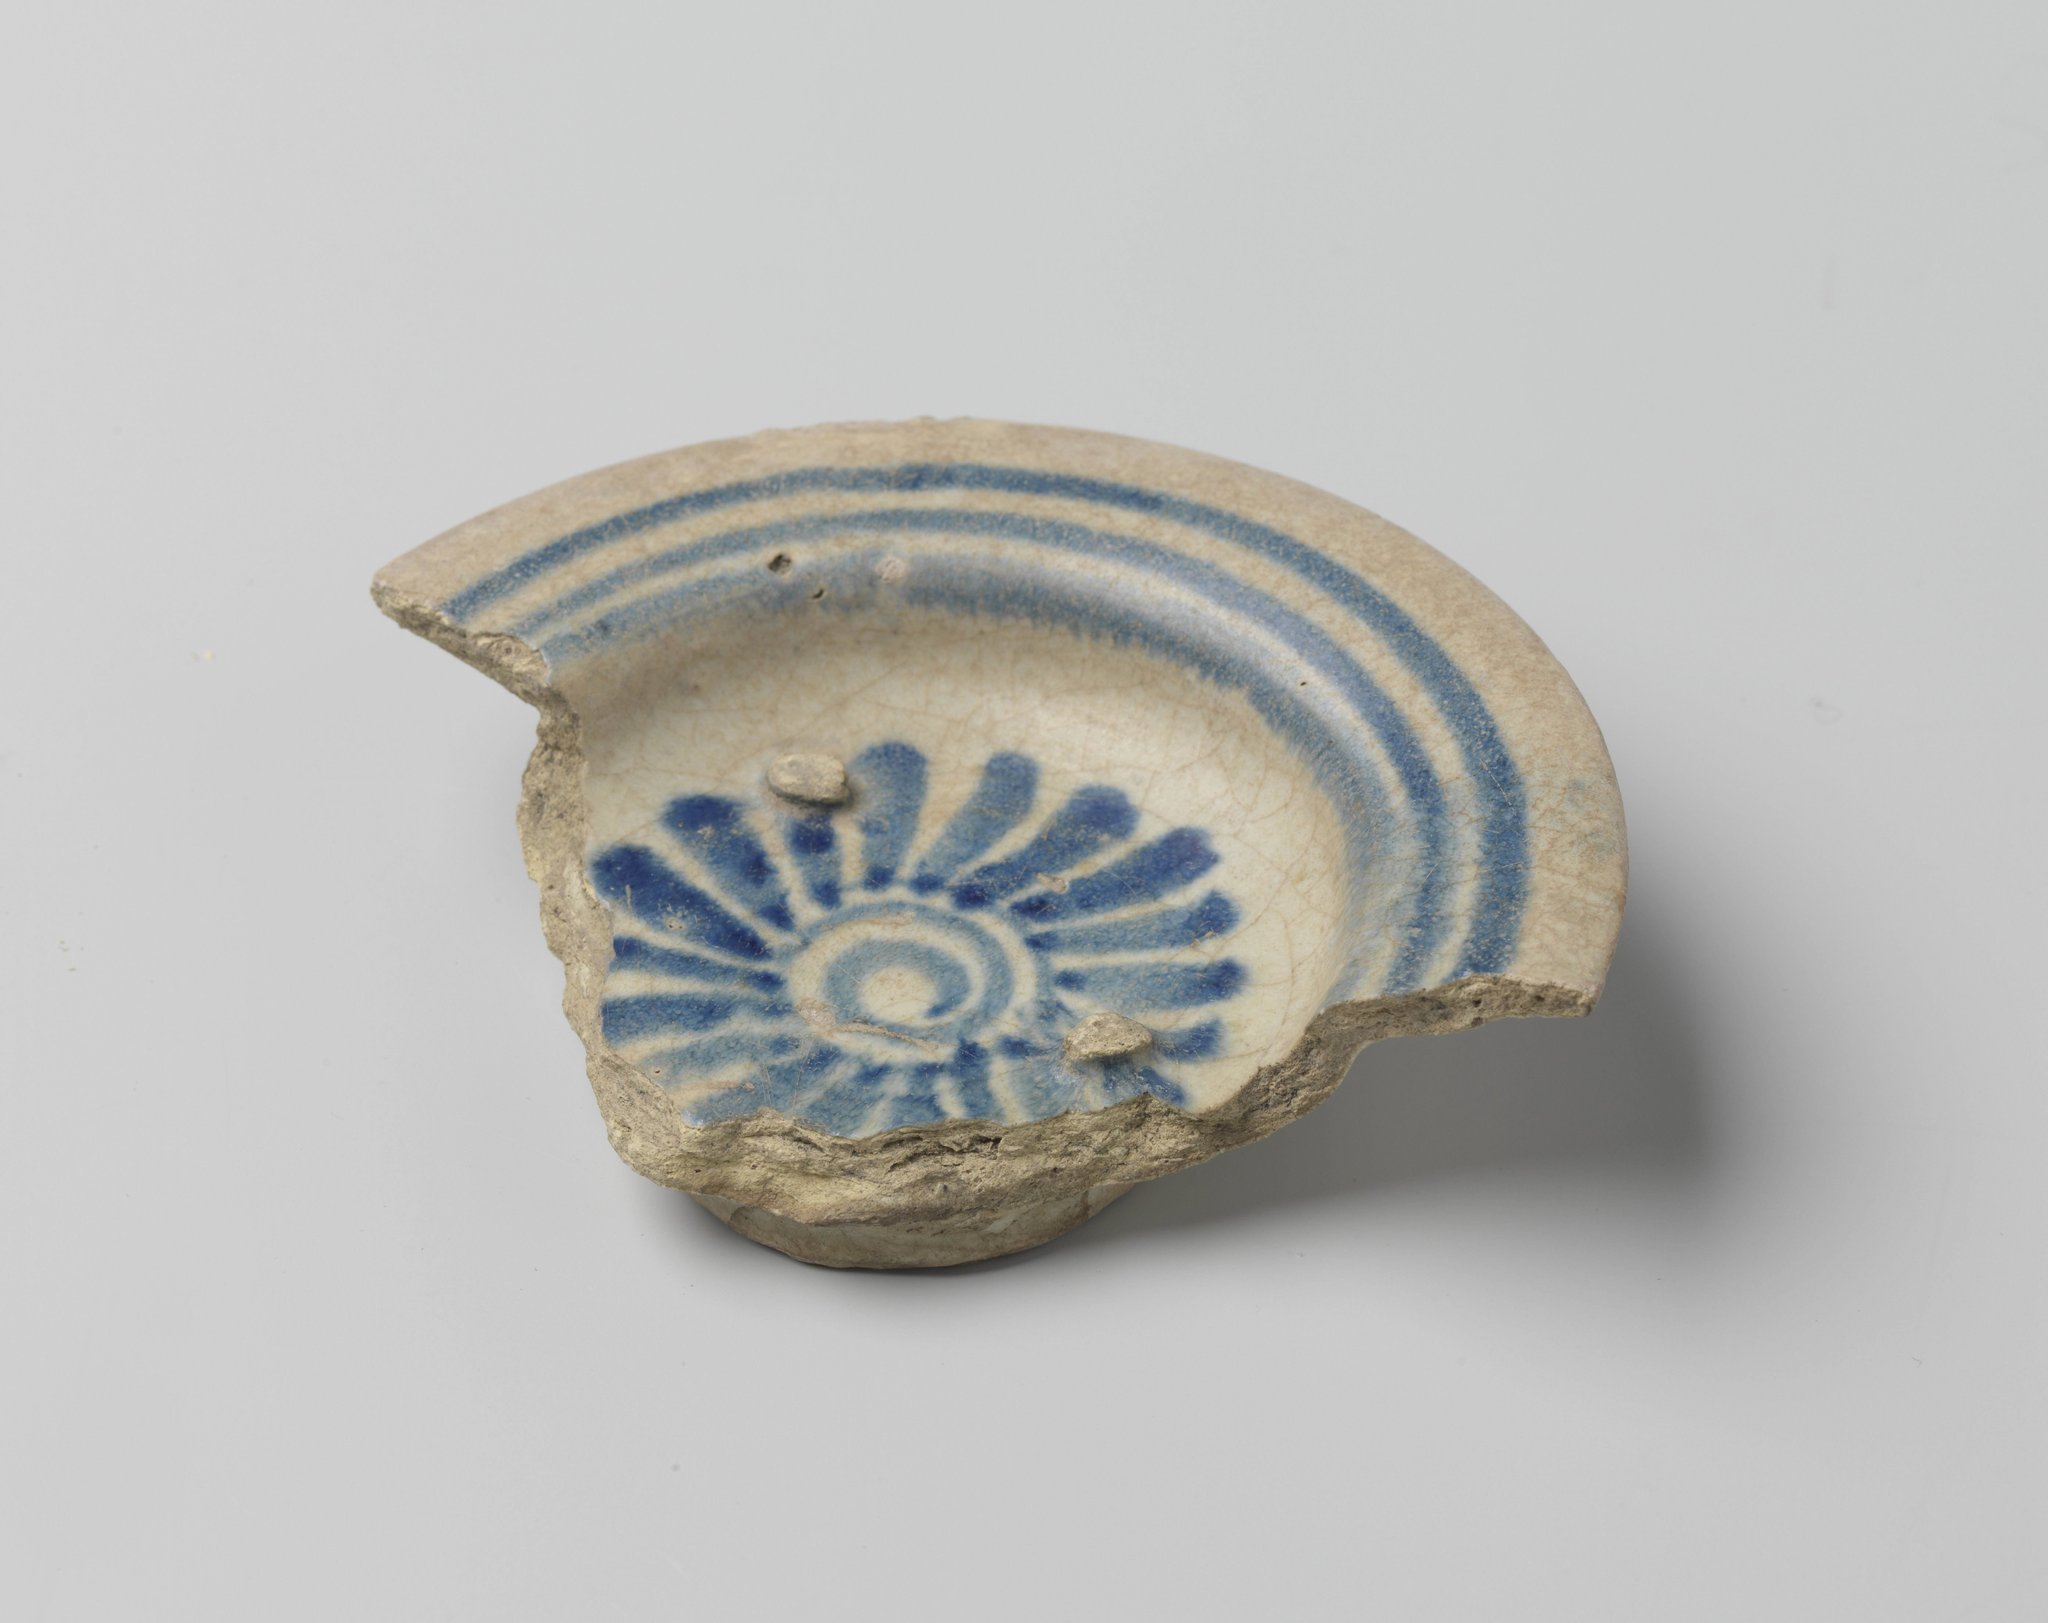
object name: fragment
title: Schotel van aardewerk versierd met blauw geometrische ornamenten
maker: Anonymous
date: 1550-1575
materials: earthenware, glaze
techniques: maiolica, painted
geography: italy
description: Fragment van een schotel van blauw beschilderde majolica, op het plat versierd met een ster- of bloemvormig ornament en op de rand concentrische cirkels. Opgegraven in Londen.